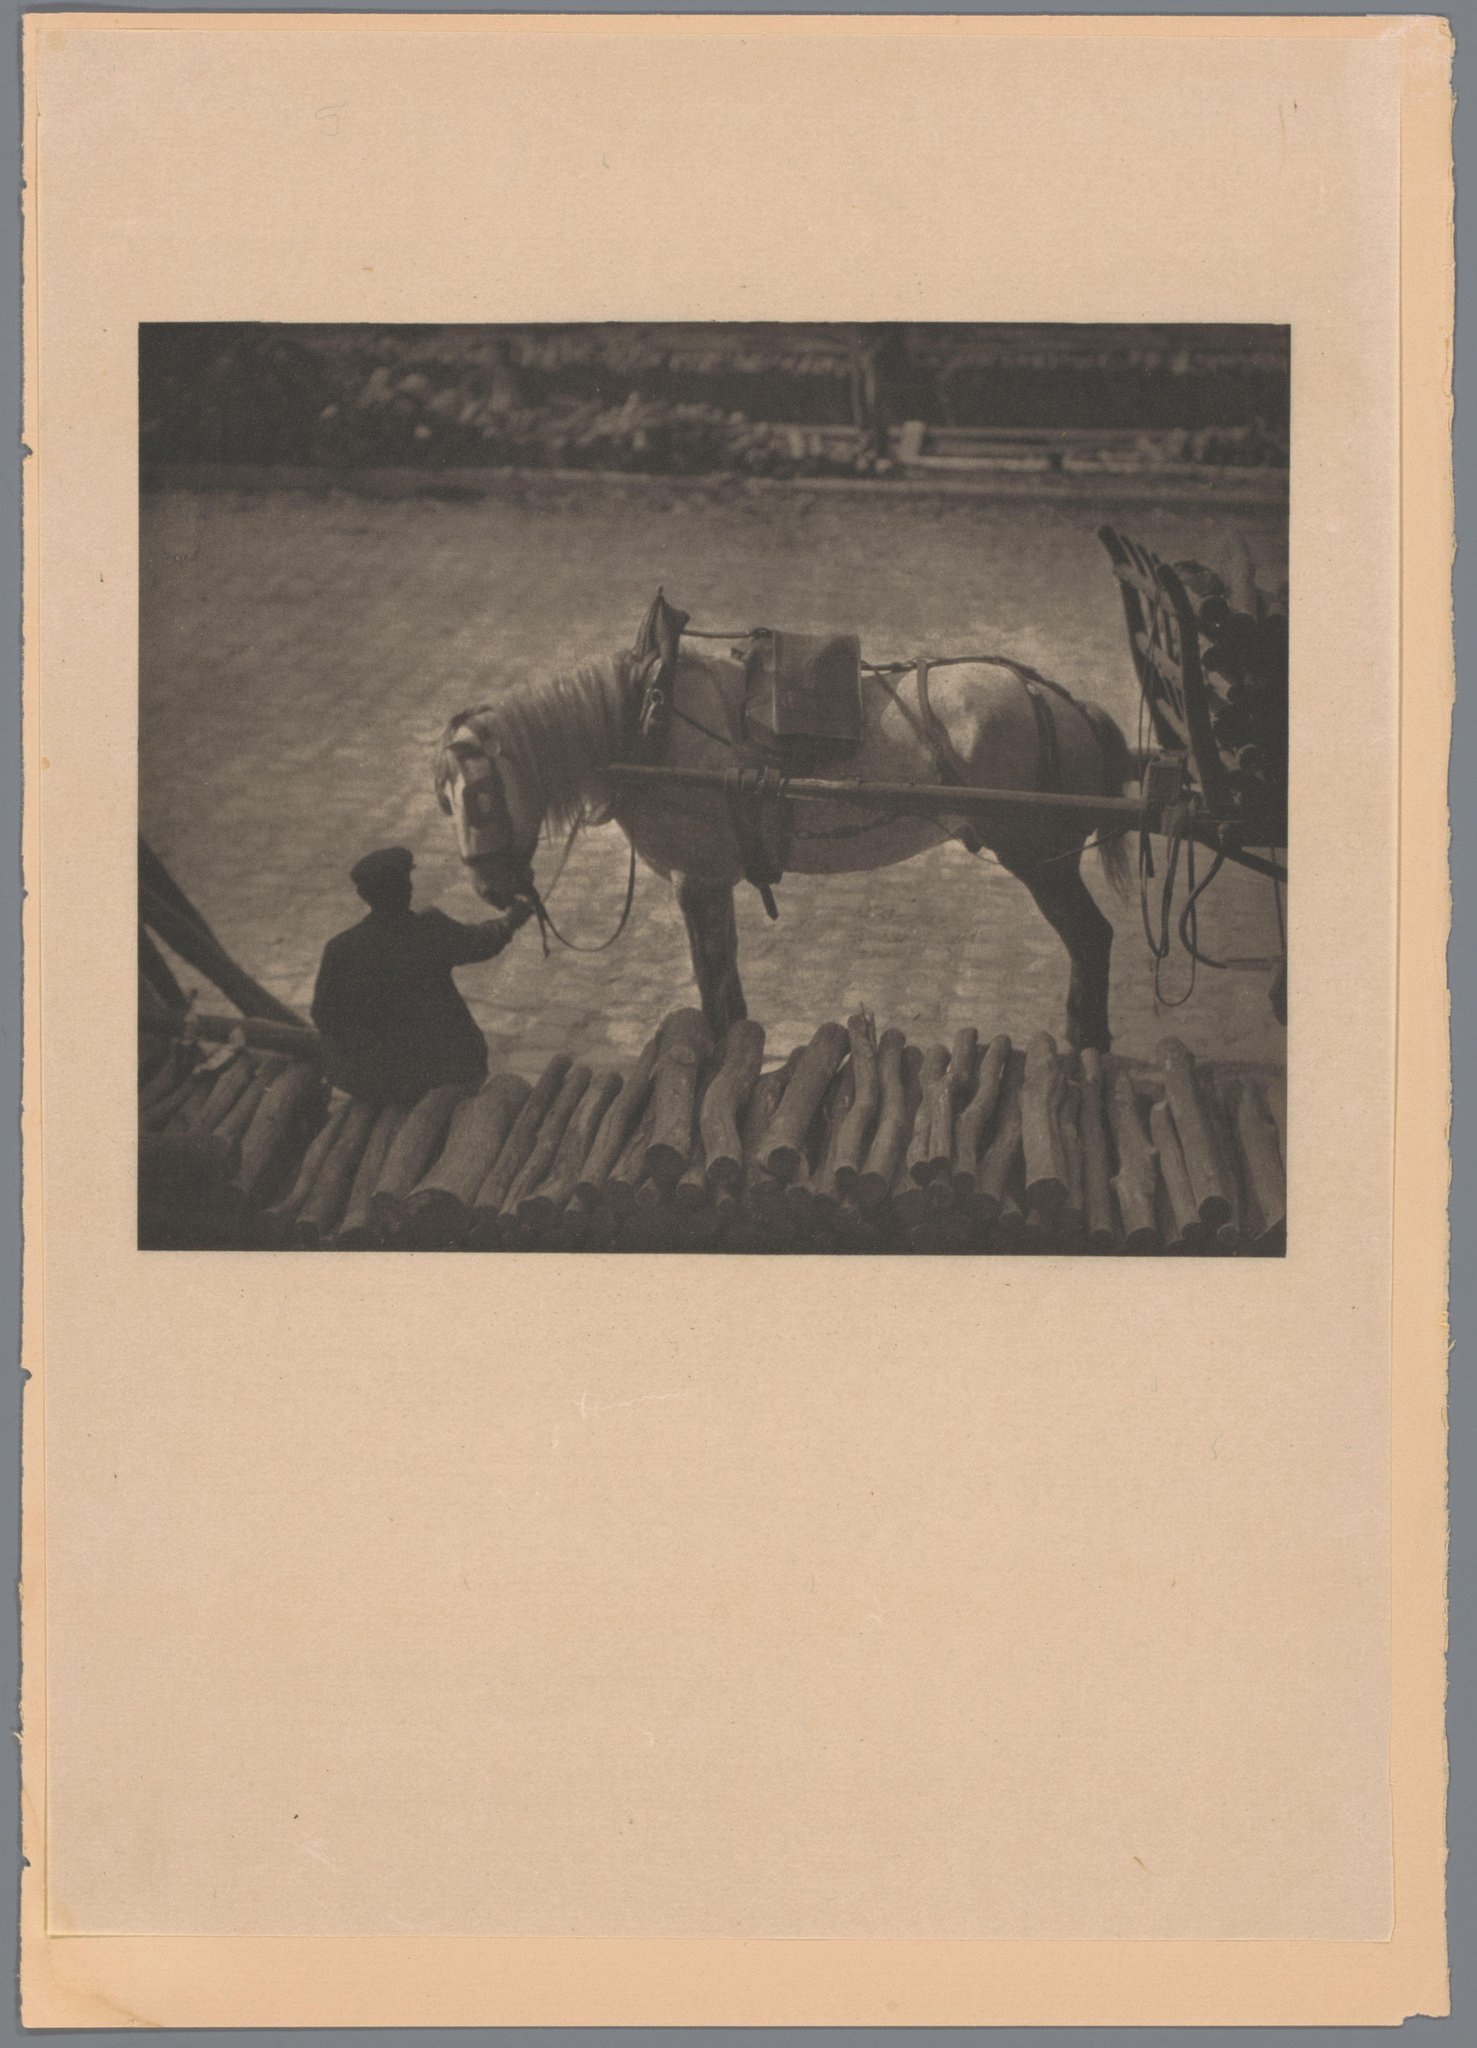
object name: photomechanical print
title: Paard voor een wagen, Parijs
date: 1911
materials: cardboard, paper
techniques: photoaquatint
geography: paris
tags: animal traction, animal-drawn vehicle (carriage etc.), paris